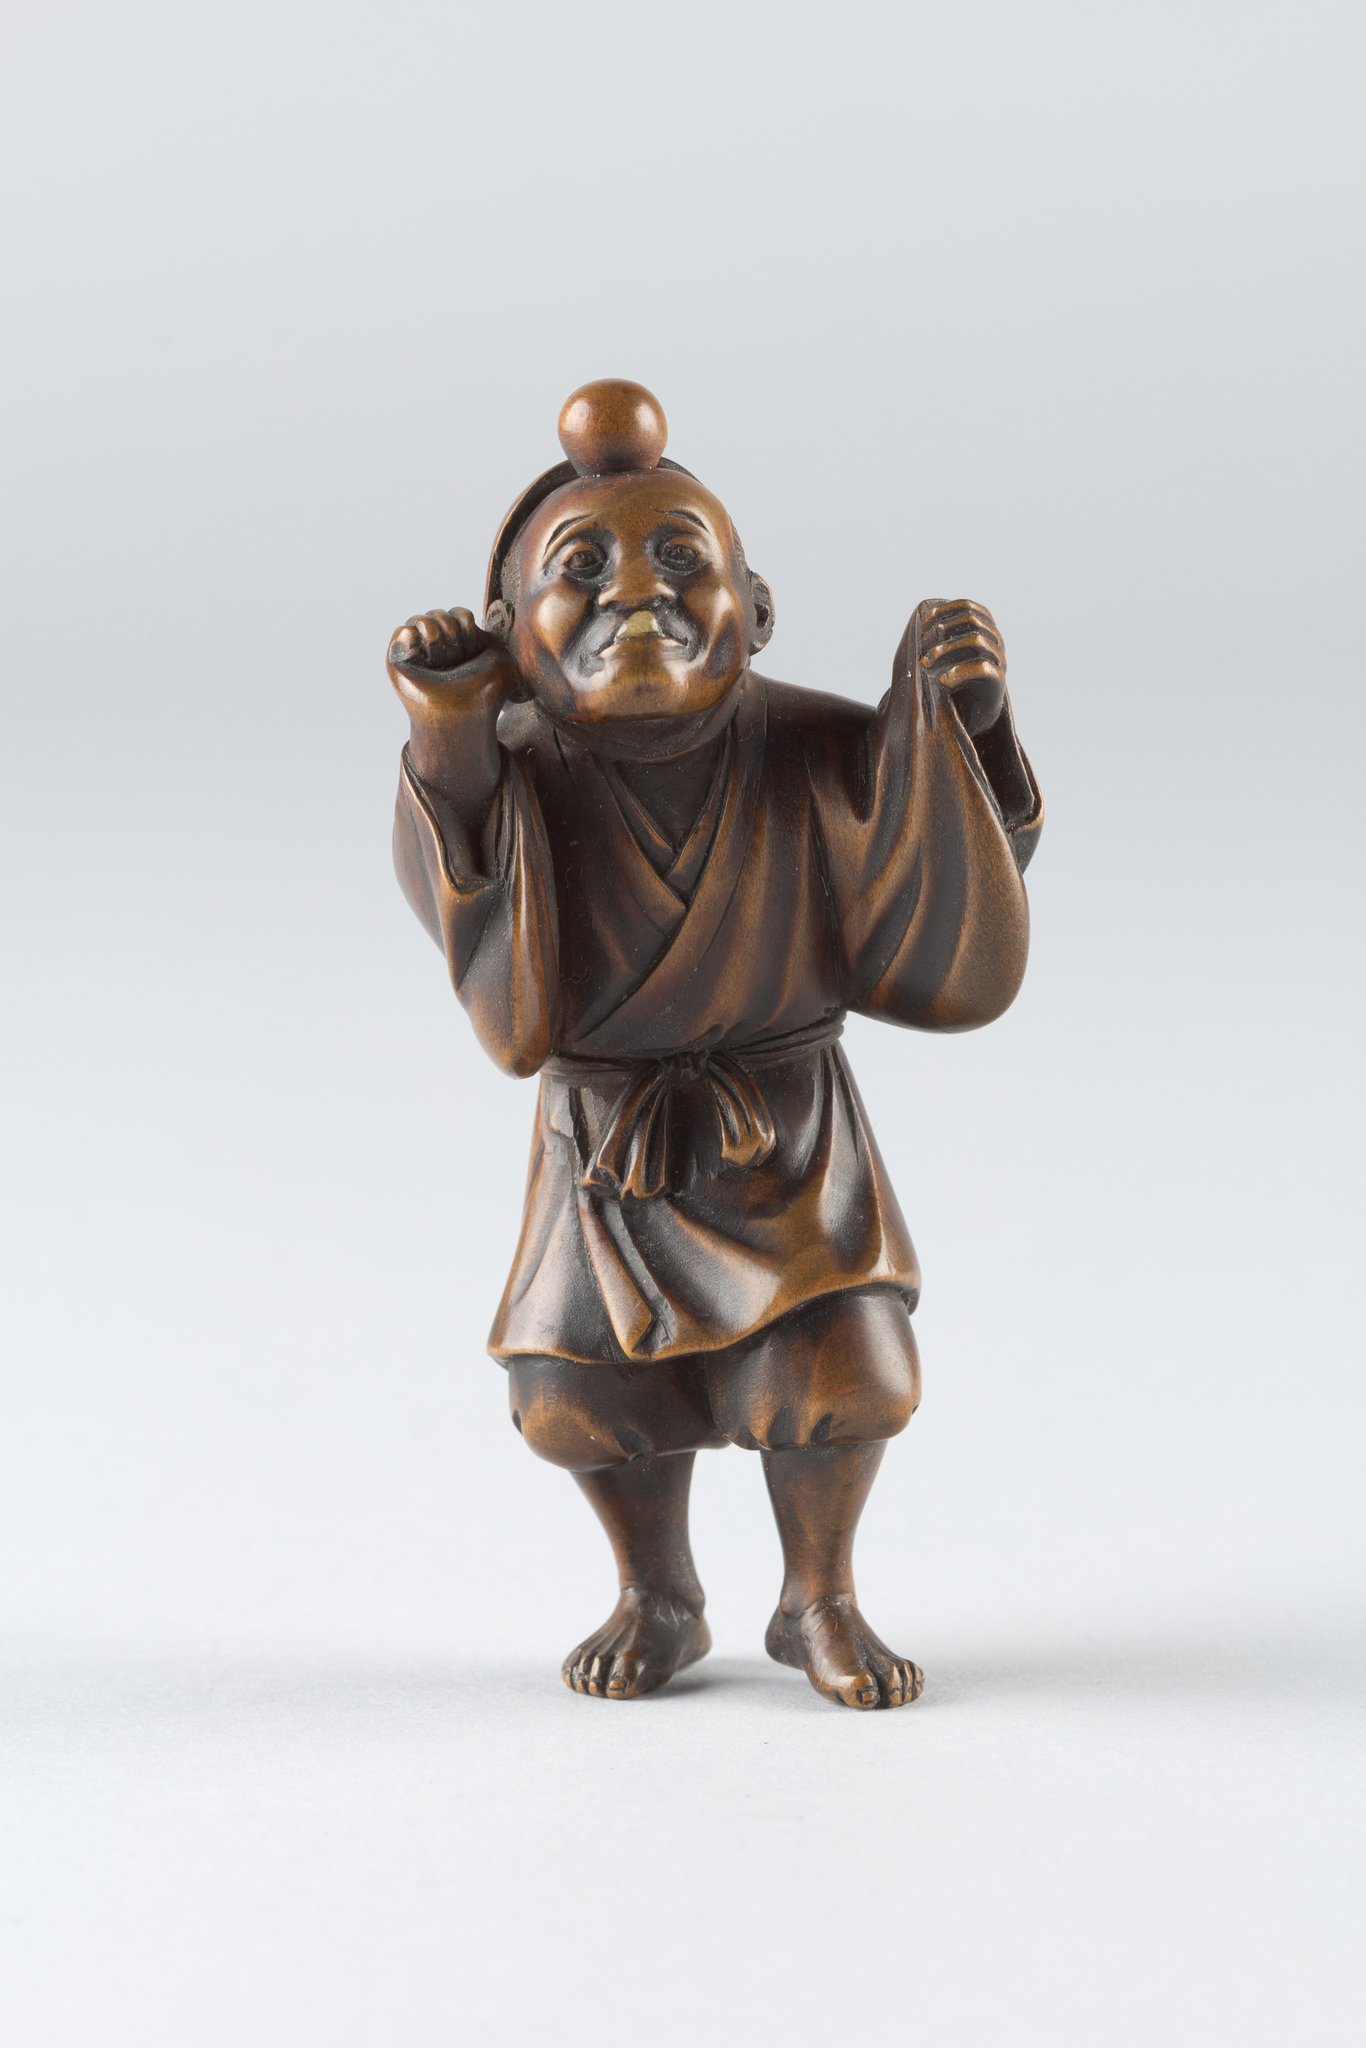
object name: netsuke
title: Netsuke of Boy Wearing a Mask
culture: japanese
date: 1701-1800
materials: wood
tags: masks,boys